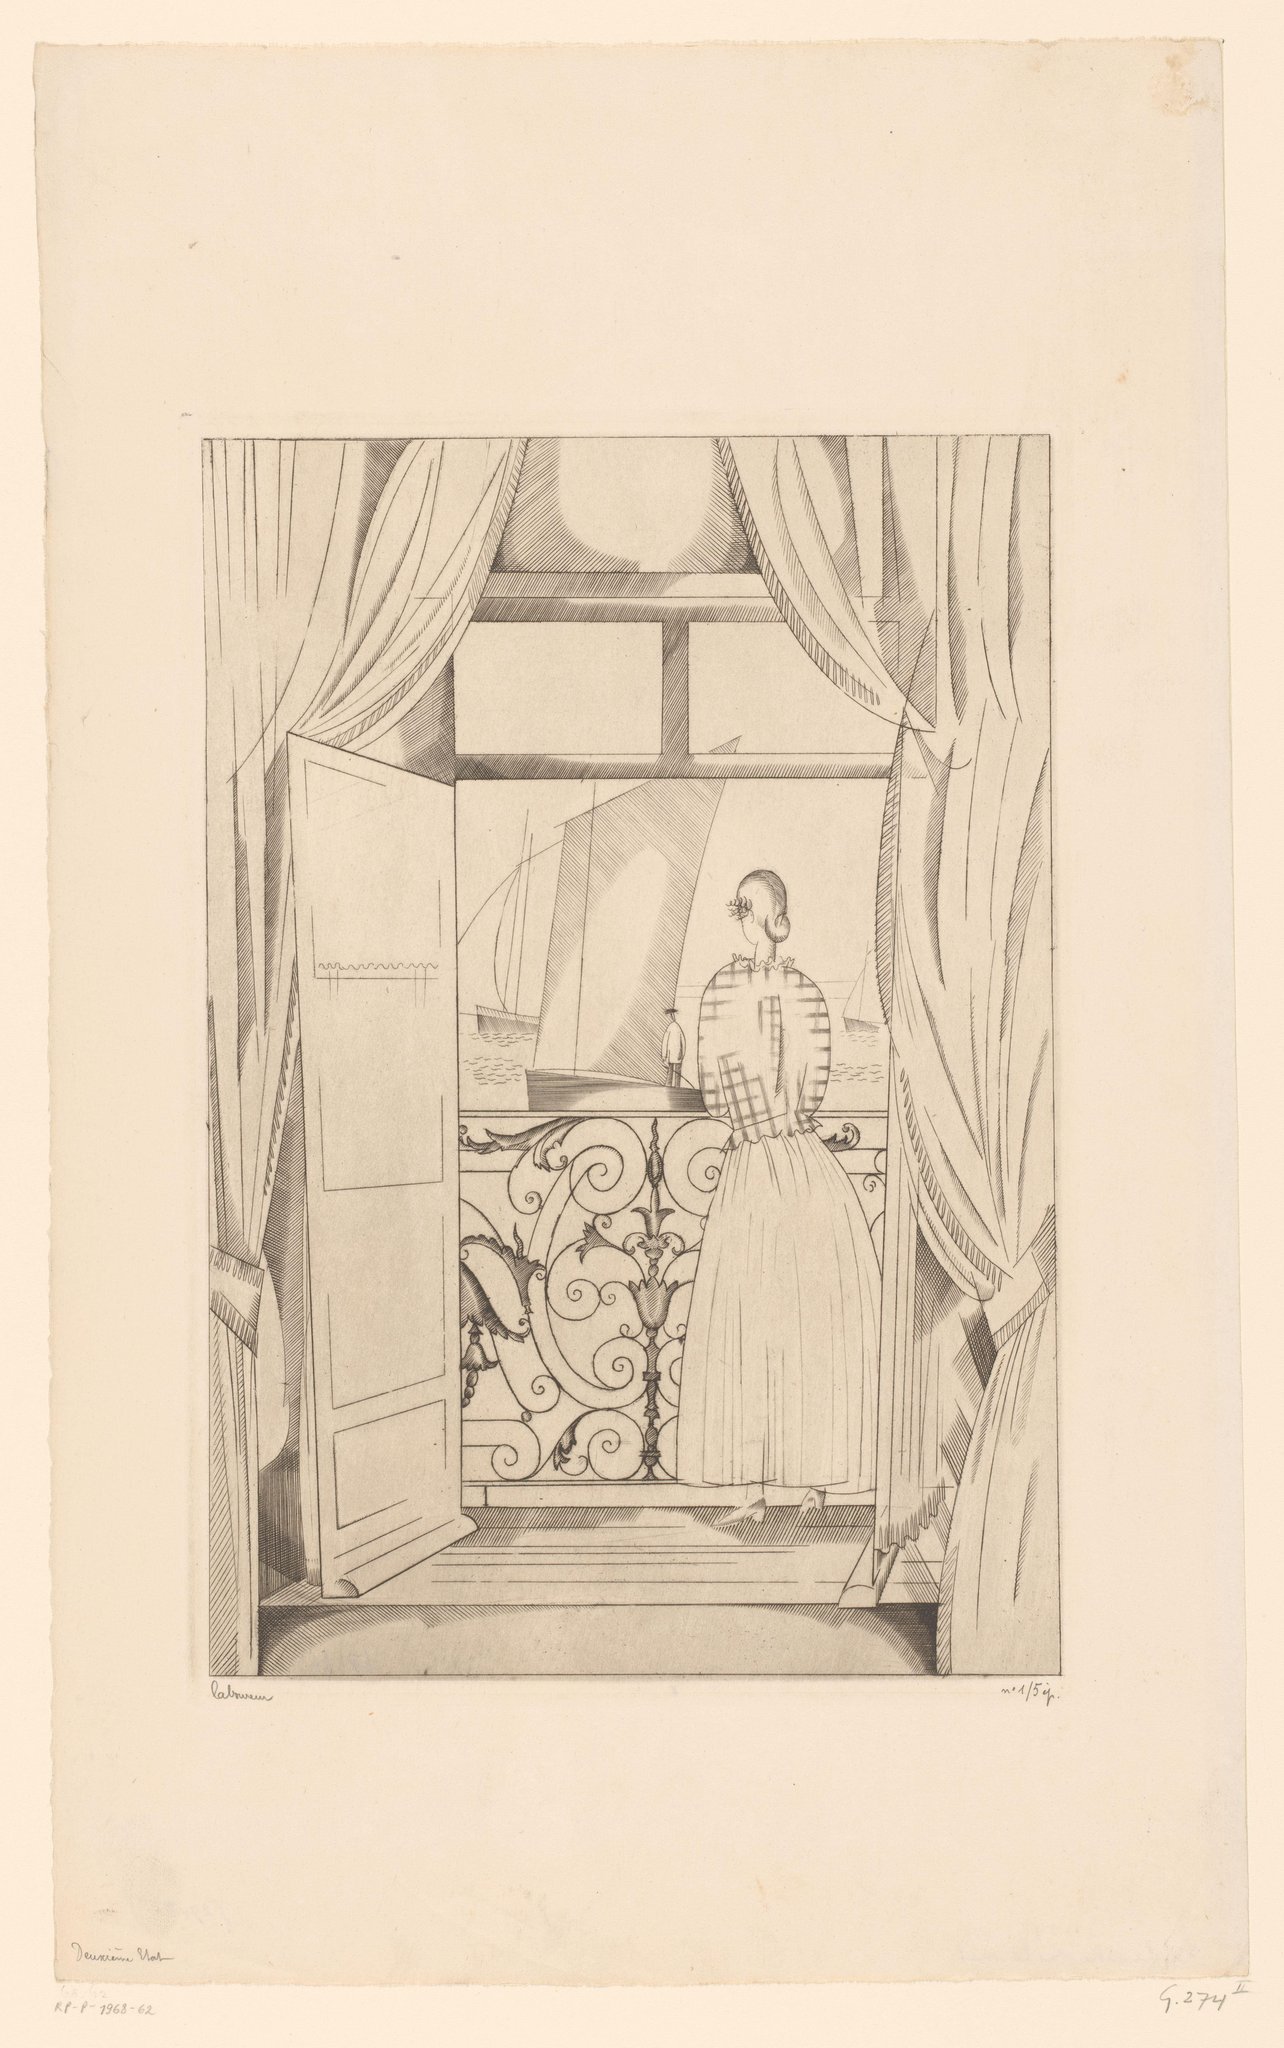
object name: print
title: Zeezicht door een raam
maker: jean emile laboureur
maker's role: draughtsman, print maker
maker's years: 1877-1943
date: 1923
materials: paper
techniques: drypoint, engraving, intaglio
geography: france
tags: sea (seascape), human figure at (open) window, seen from inside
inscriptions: collector's mark: Lugt 2228, collector's mark: Lugt 2760